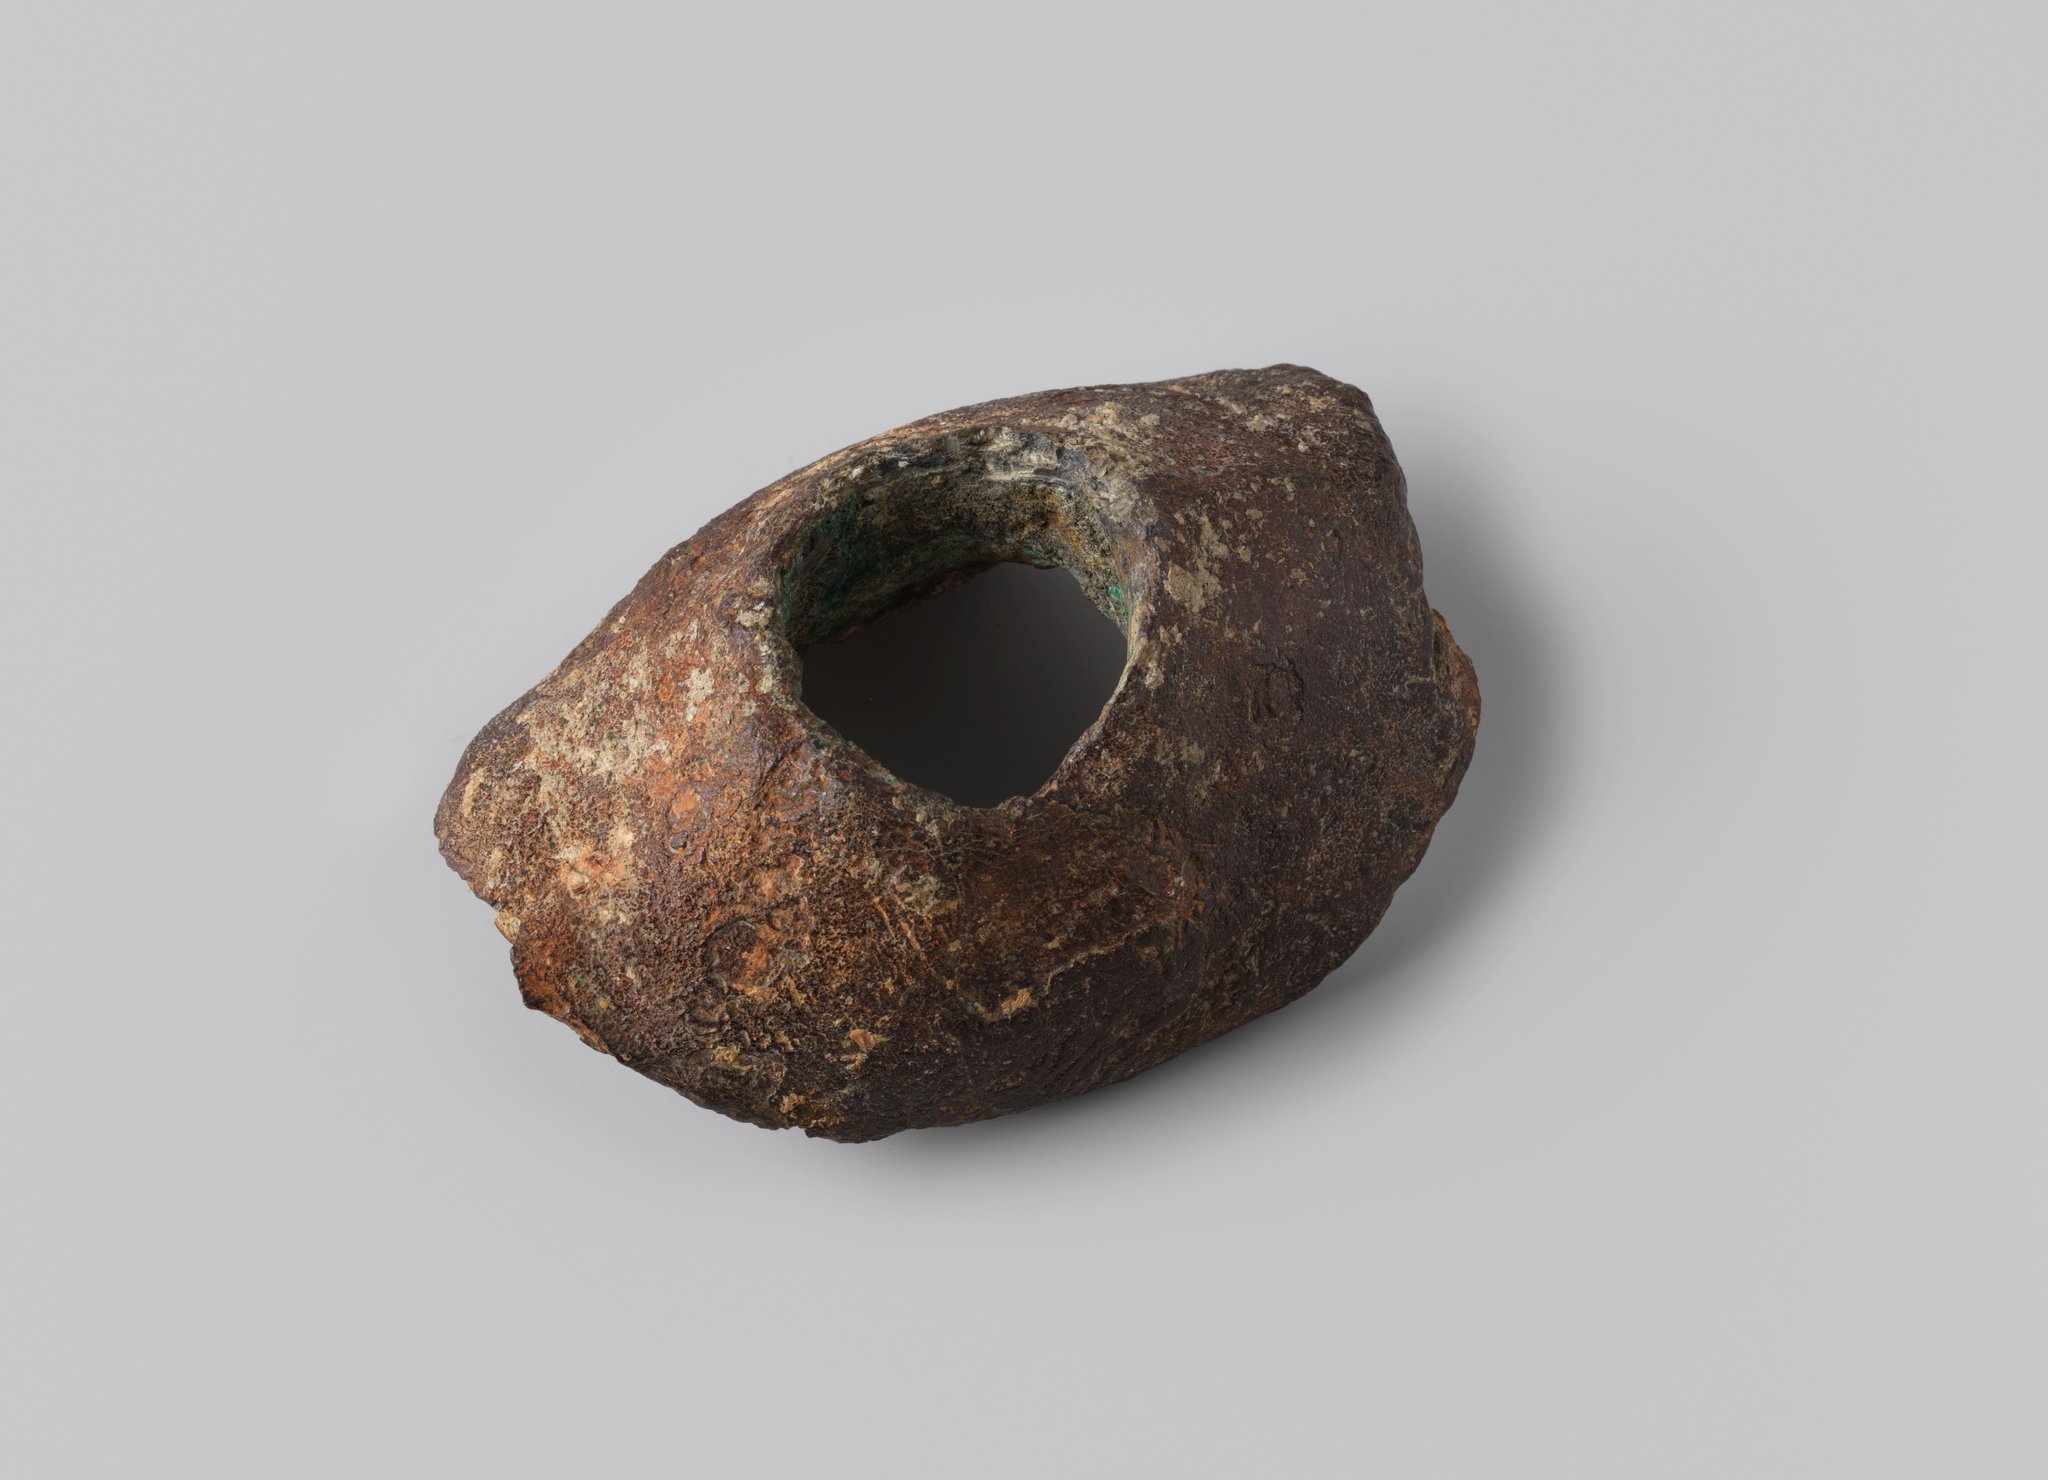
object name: flange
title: Flens uit het wrak van de Oost-Indiëvaarder Hollandia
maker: Anonymous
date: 1700-1743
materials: copper, lead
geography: netherlands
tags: verenigde oostindische compagnie, hollandia (schip), annet